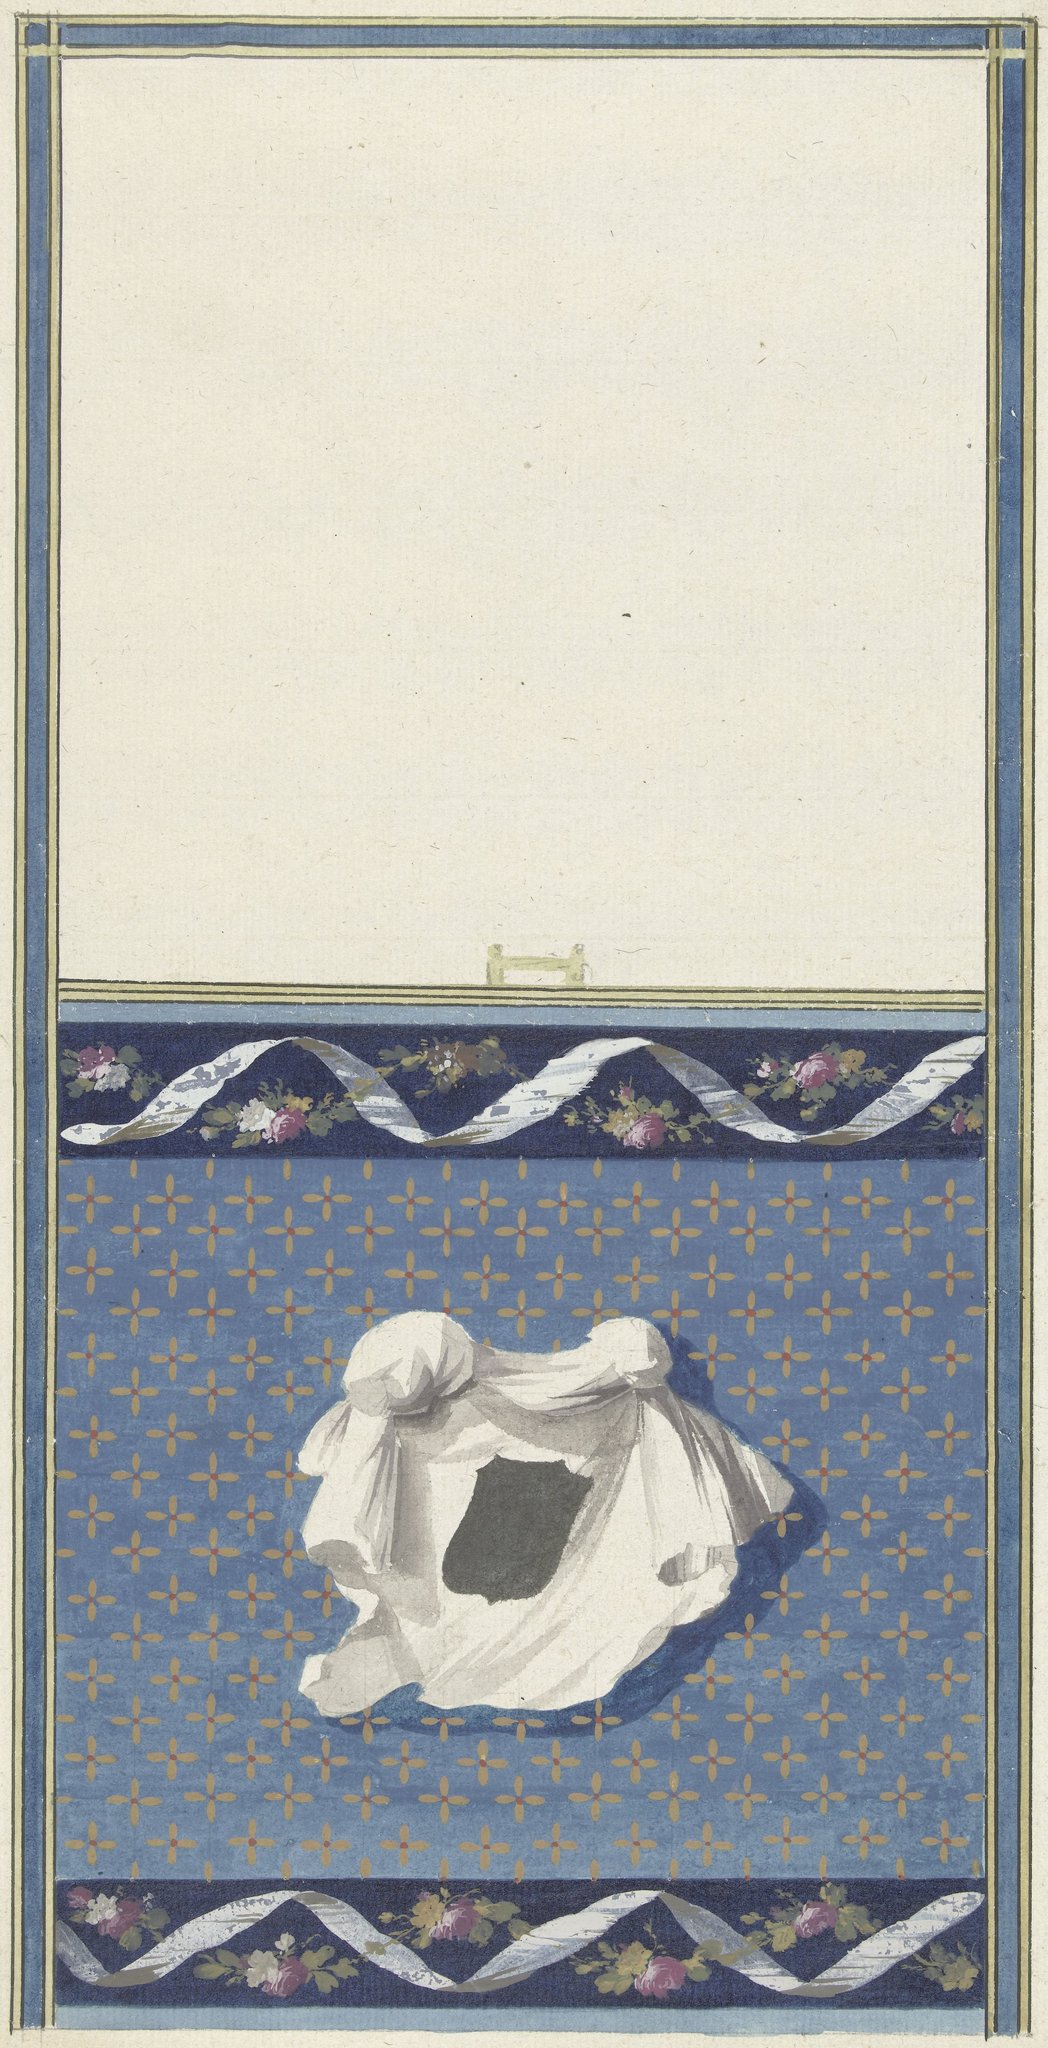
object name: drawing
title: Ontwerp voor kamerversiering met verticaal twee panelen, de onderste met een witte doek op een sterrenfond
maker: abraham meertens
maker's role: draughtsman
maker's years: 1757-1823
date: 1767-1823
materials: paint, ink, paper, pencil, watercolor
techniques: brush, pen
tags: wall-covering